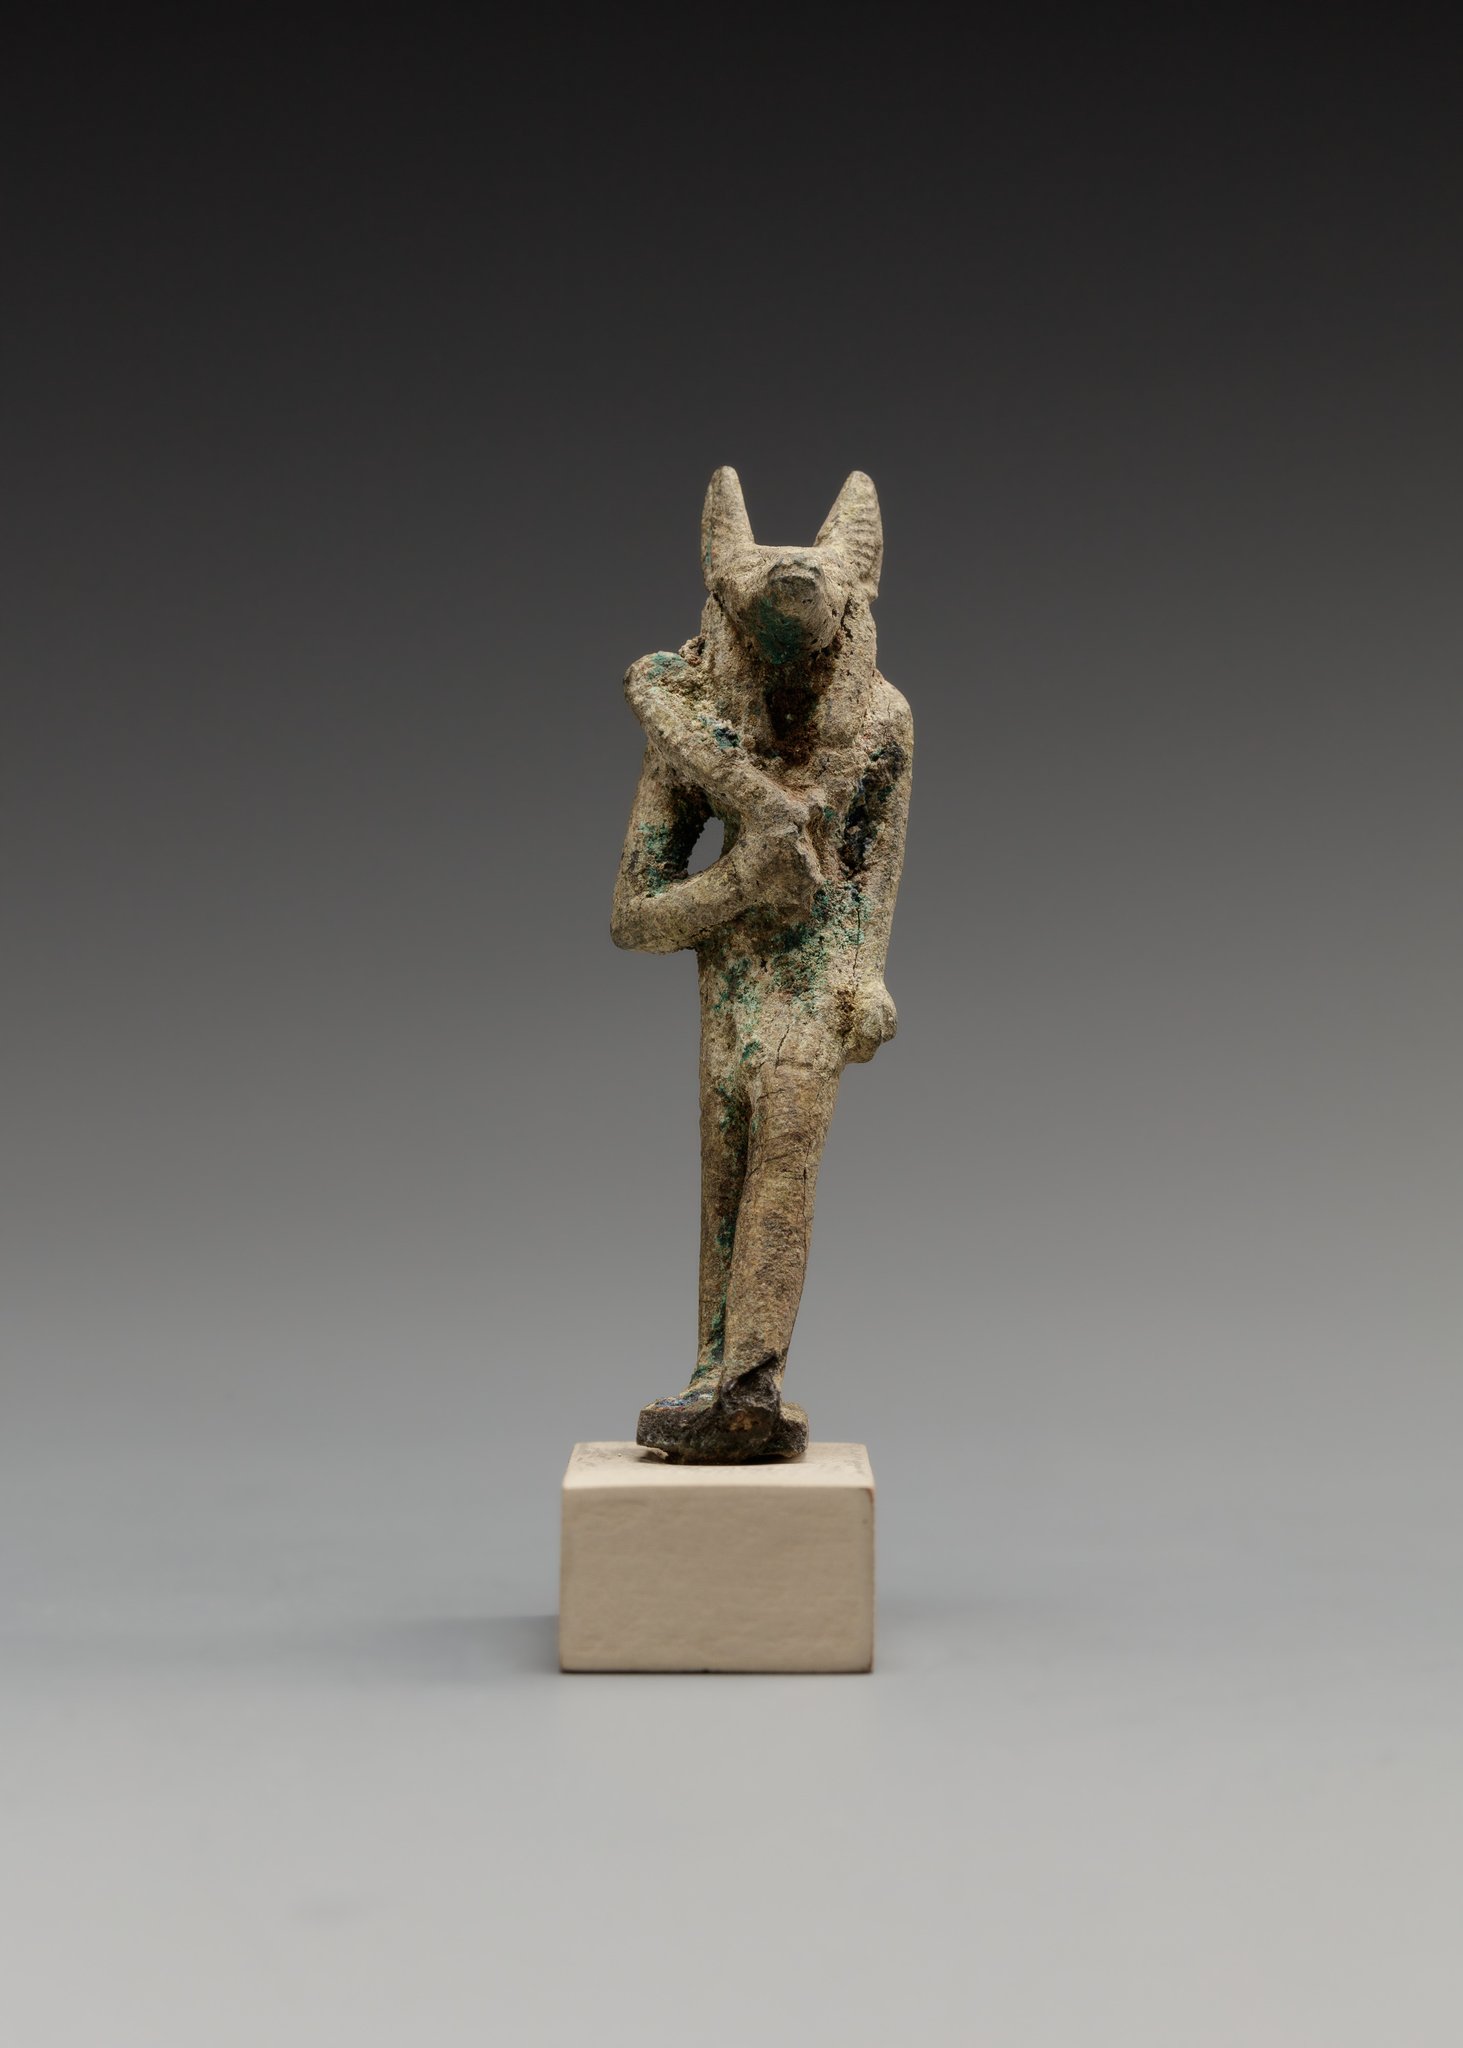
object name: statuette, anubis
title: Anubis with scepter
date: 664-630 BCE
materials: alloy, bronze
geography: egypt